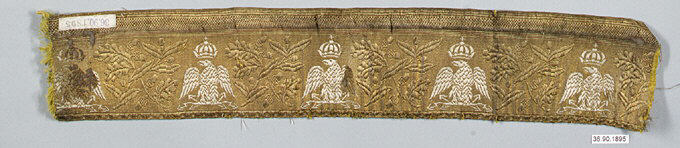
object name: galloon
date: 1801-1900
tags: birds